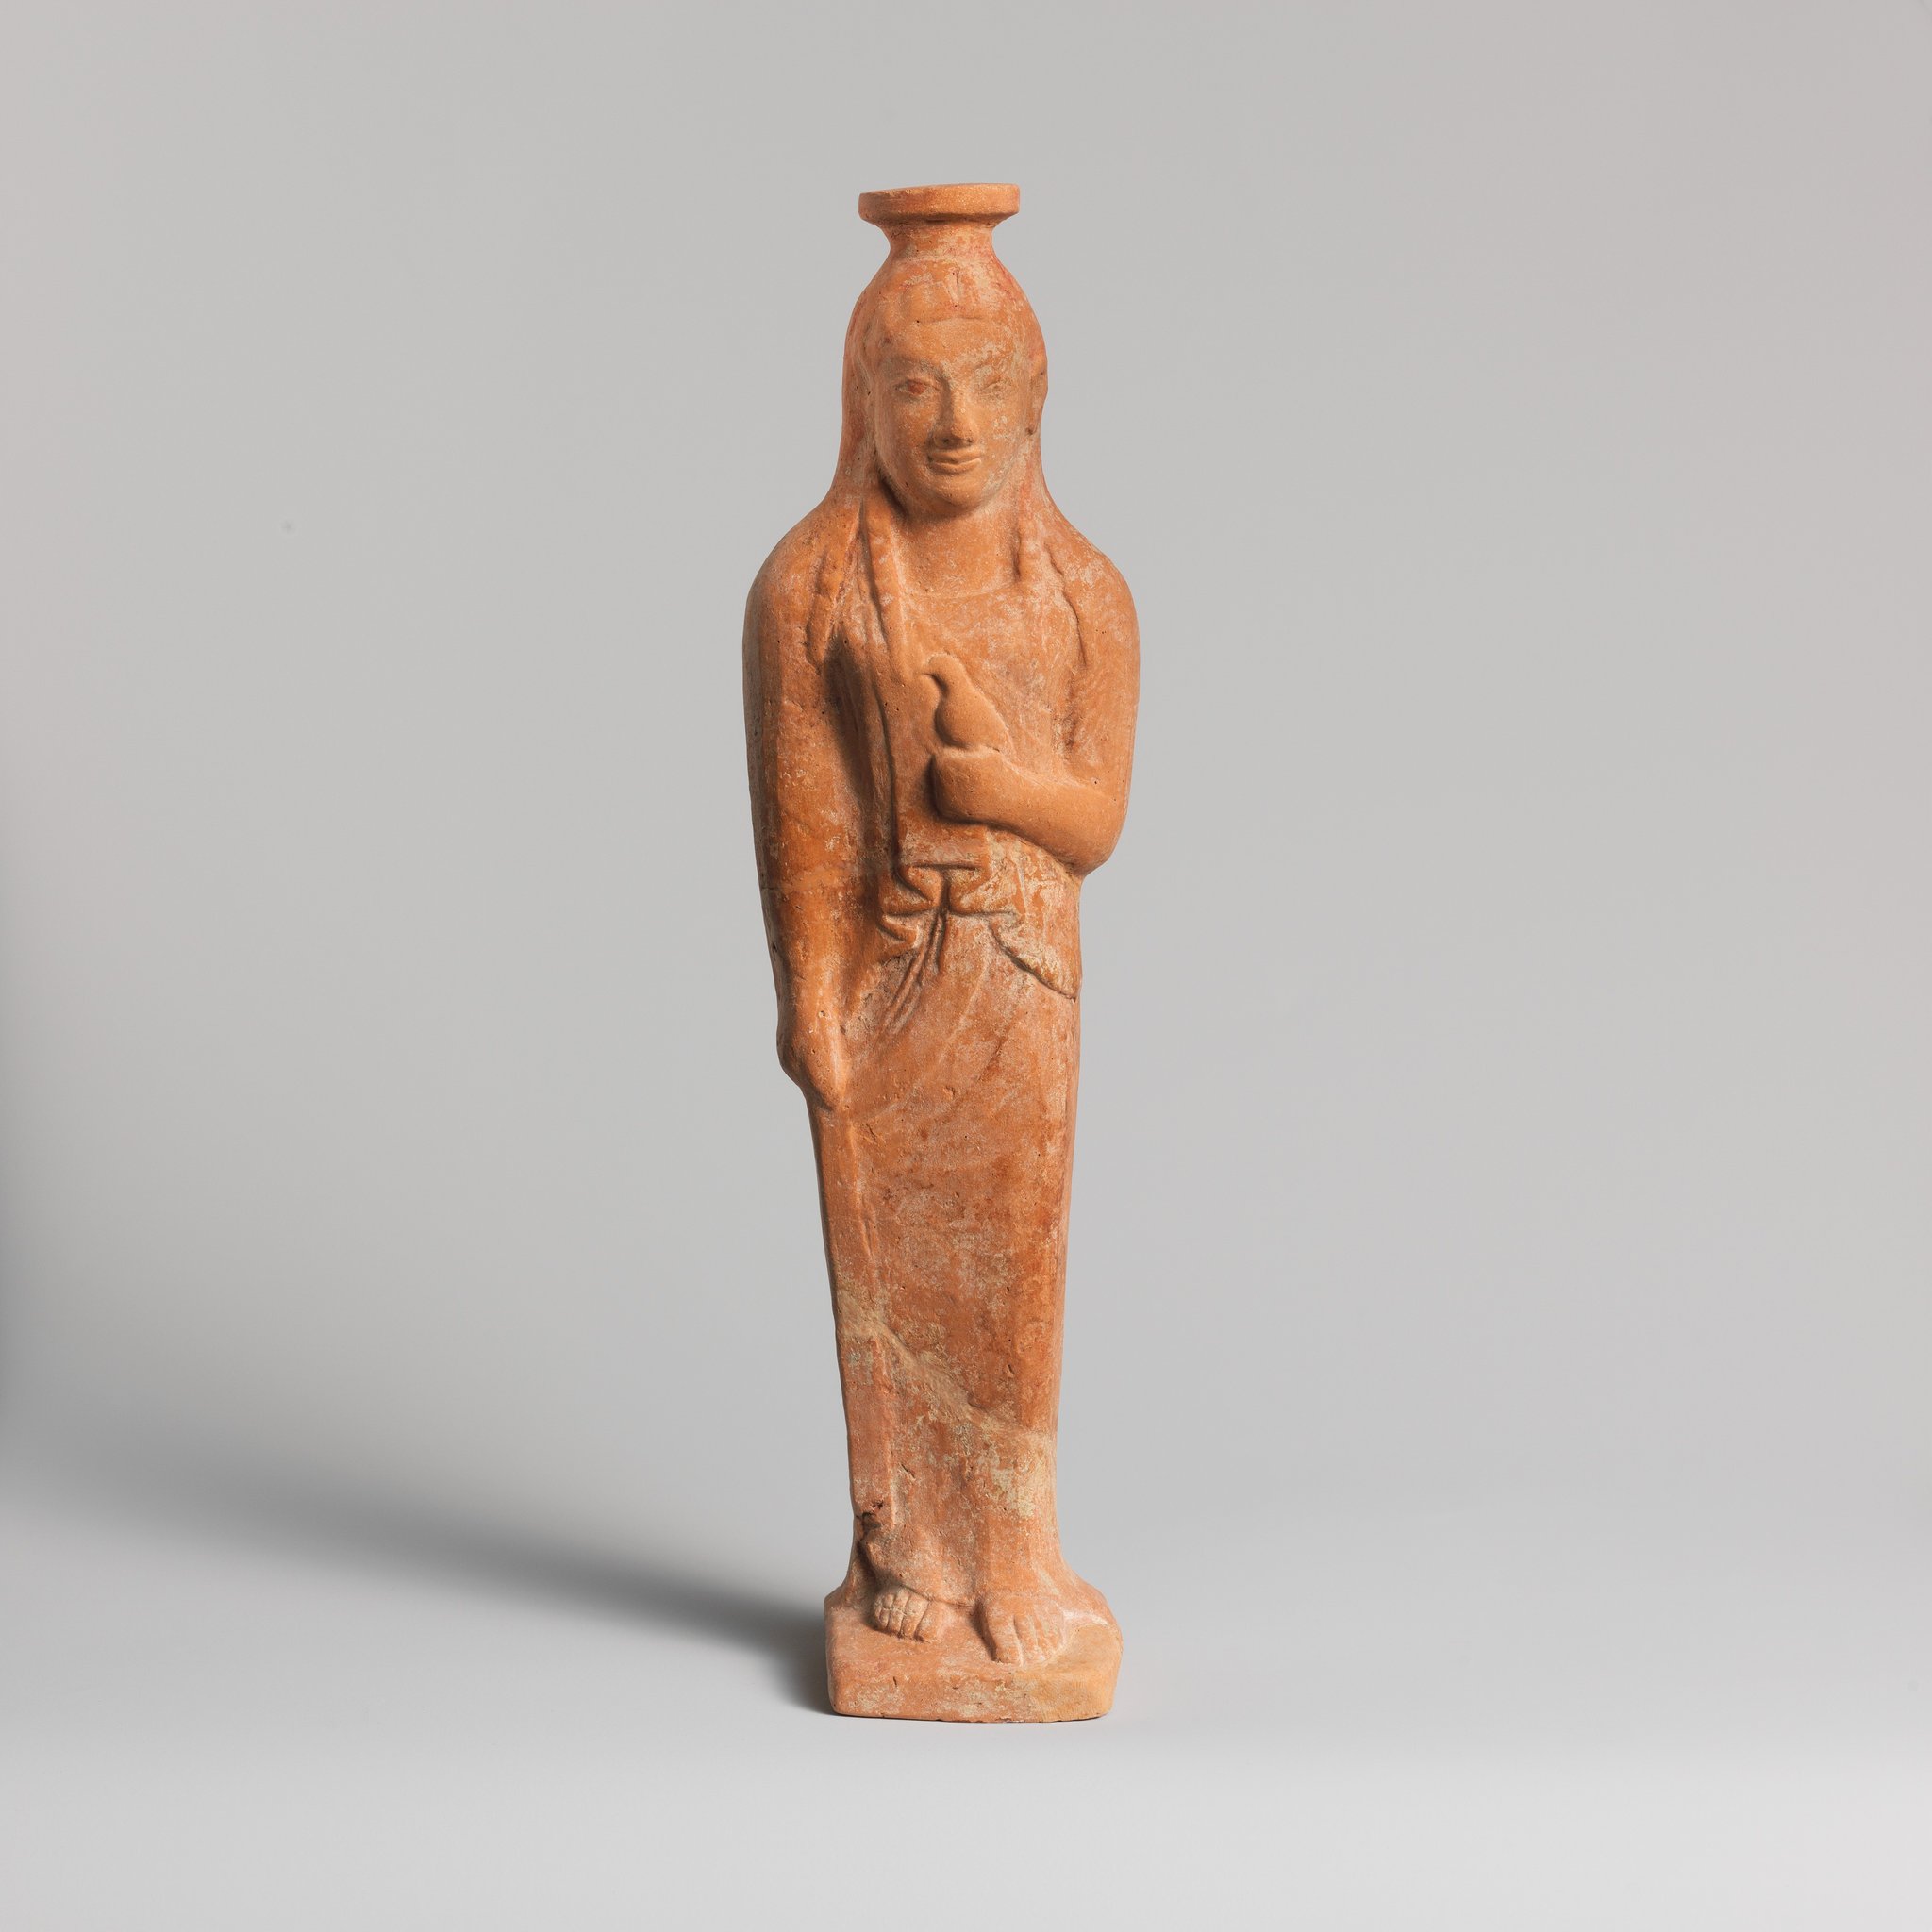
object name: alabastron in the form of a woman holding a dove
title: Terracotta vase in the form of a woman holding a bird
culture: east greek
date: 600-501 BCE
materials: terracotta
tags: birds,women